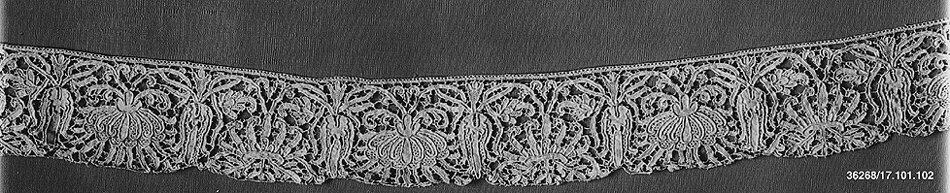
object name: piece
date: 1601-1633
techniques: lace